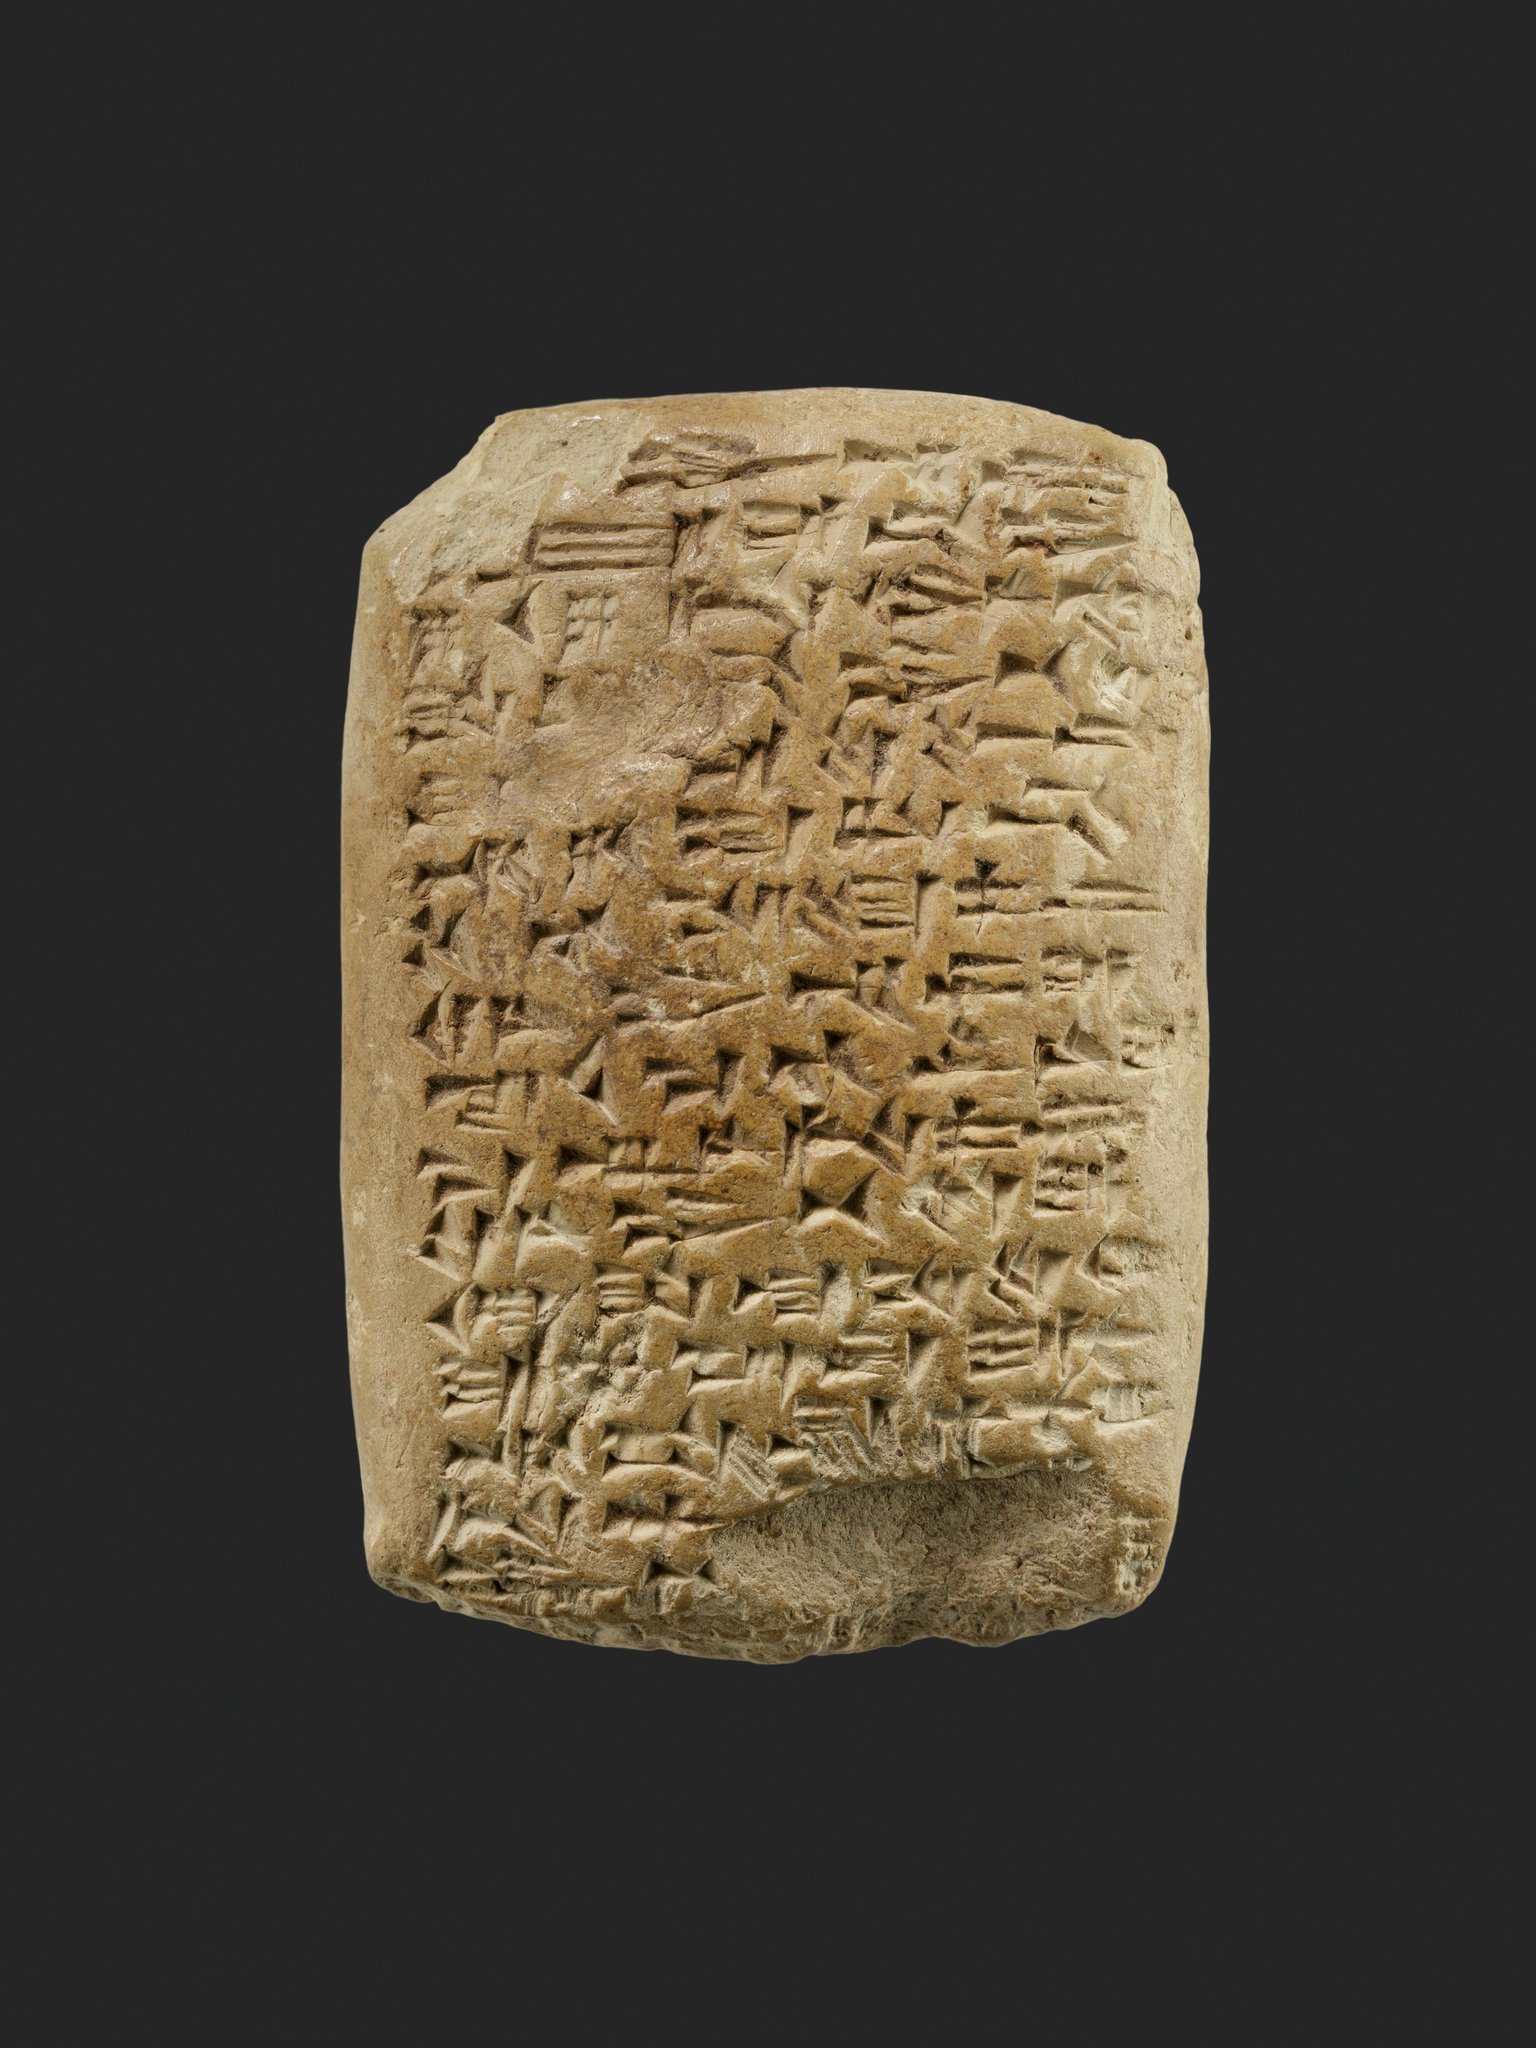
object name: tablet, amarna letter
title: Amarna letter: Royal Letter from Abi-milku of Tyre to the king of Egypt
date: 1353-1336 BCE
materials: clay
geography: middle egypt